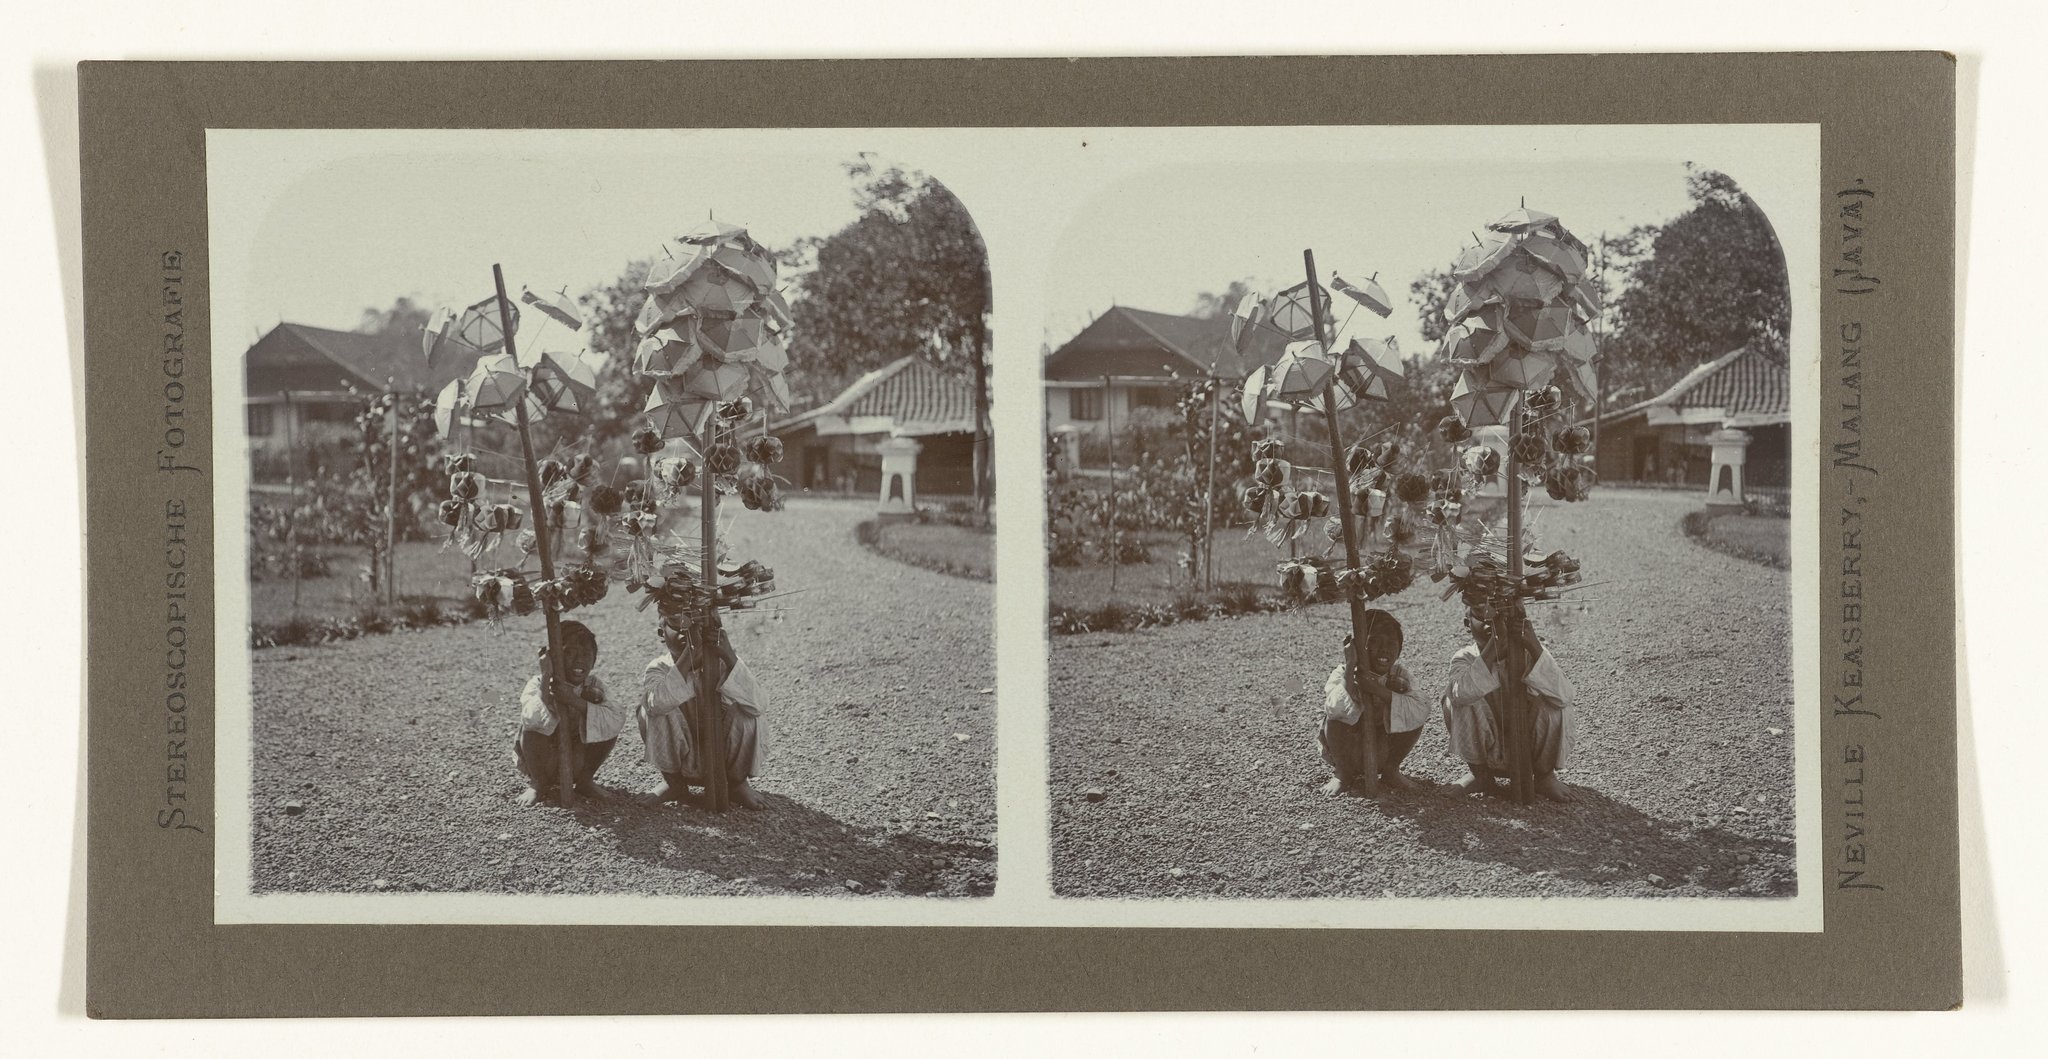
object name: stereograph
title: Kinderspeelgoed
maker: neville keasberry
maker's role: fotograaf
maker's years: 1866-1944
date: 1900-1935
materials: cardboard, paper, photographic support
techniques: albumen print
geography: malang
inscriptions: inscription: ‘Stereoscopische Fotografie’, annotation: ‘S 8 No 90. Kinderspeelgoed’, signature: ‘Neville Keasberry, Malang (Java)’